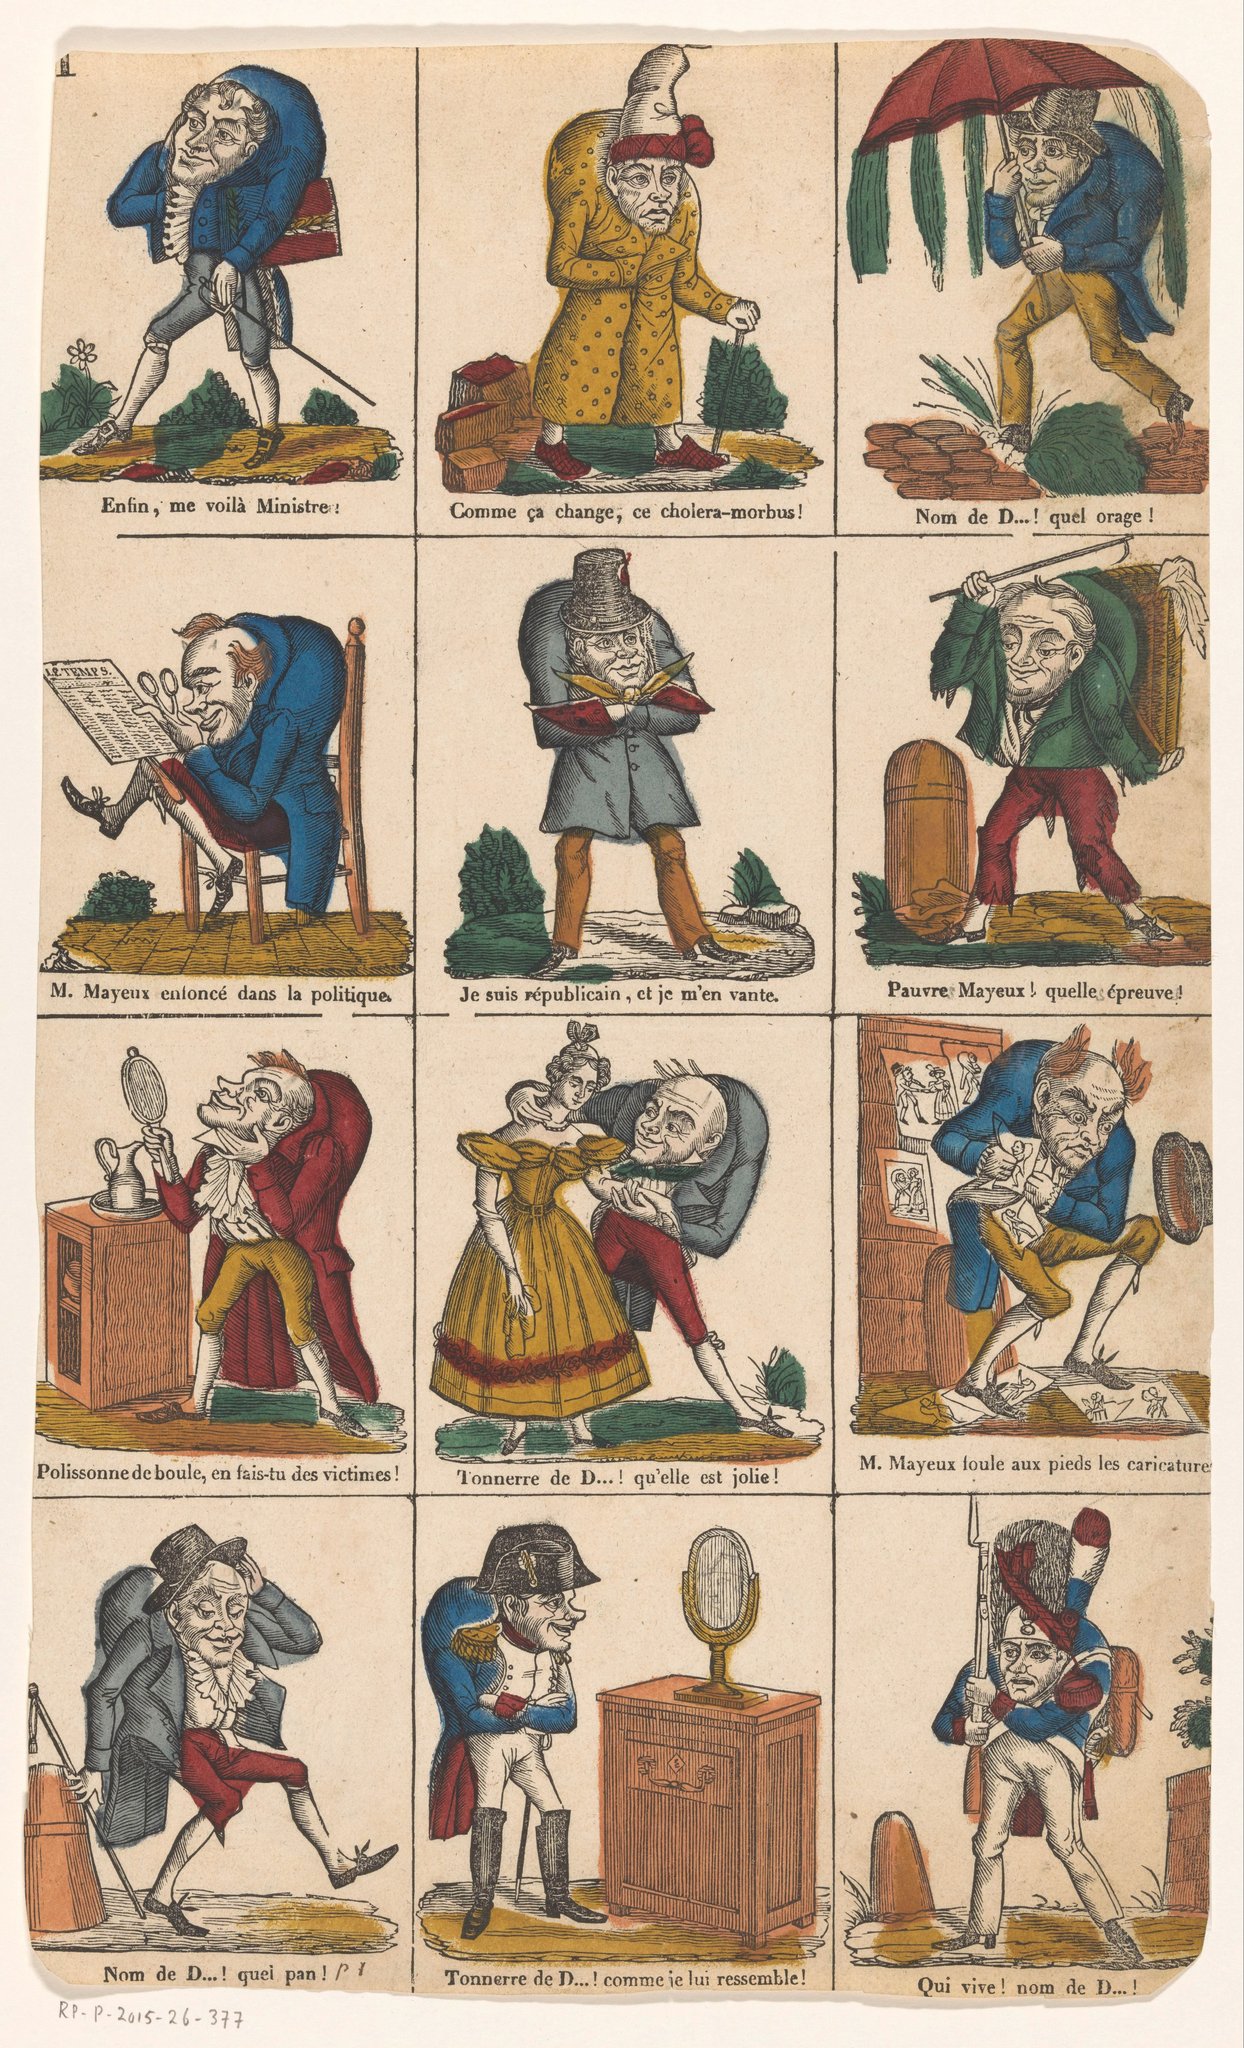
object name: popular print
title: Mr. Mayeux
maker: Anonymous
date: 1830-1850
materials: paper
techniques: hand coloring, letterpress printing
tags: hunchback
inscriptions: collector's mark: Lugt 4780, collector's mark: Lugt 2228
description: Blad met 12 voorstellingen met de gebochelde Mayeux. Onder elke afbeelding een onderschrift in het Frans.